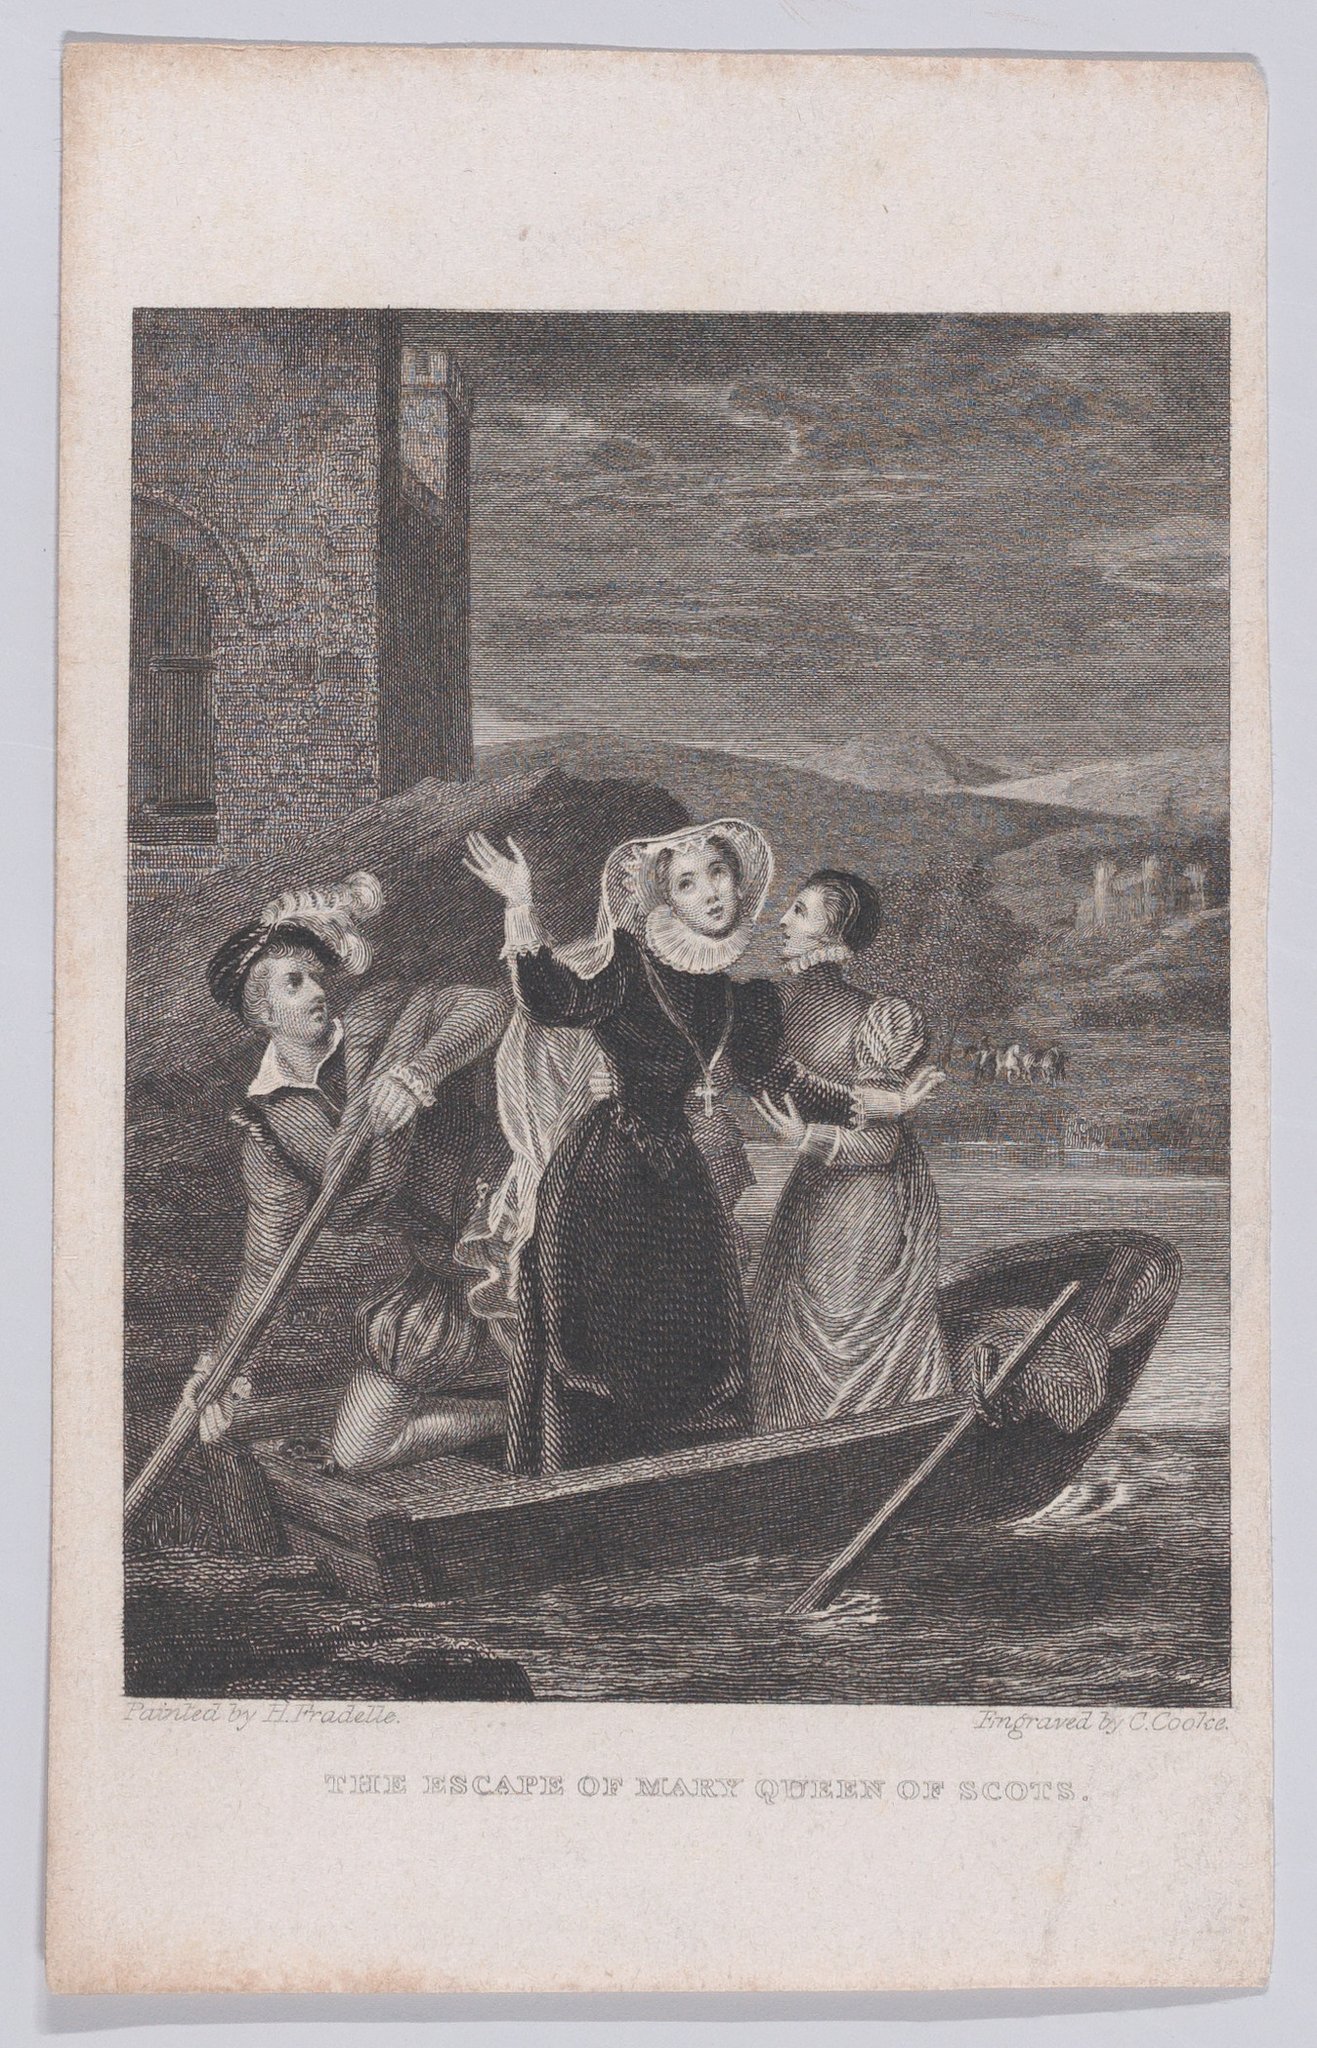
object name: print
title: The escape of Mary, Queen of Scots from Loch Leven Castle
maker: charles cooke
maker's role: artist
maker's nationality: british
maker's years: 1759-1816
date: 1831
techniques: engraving, etching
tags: men,women,boats,mary queen of scots